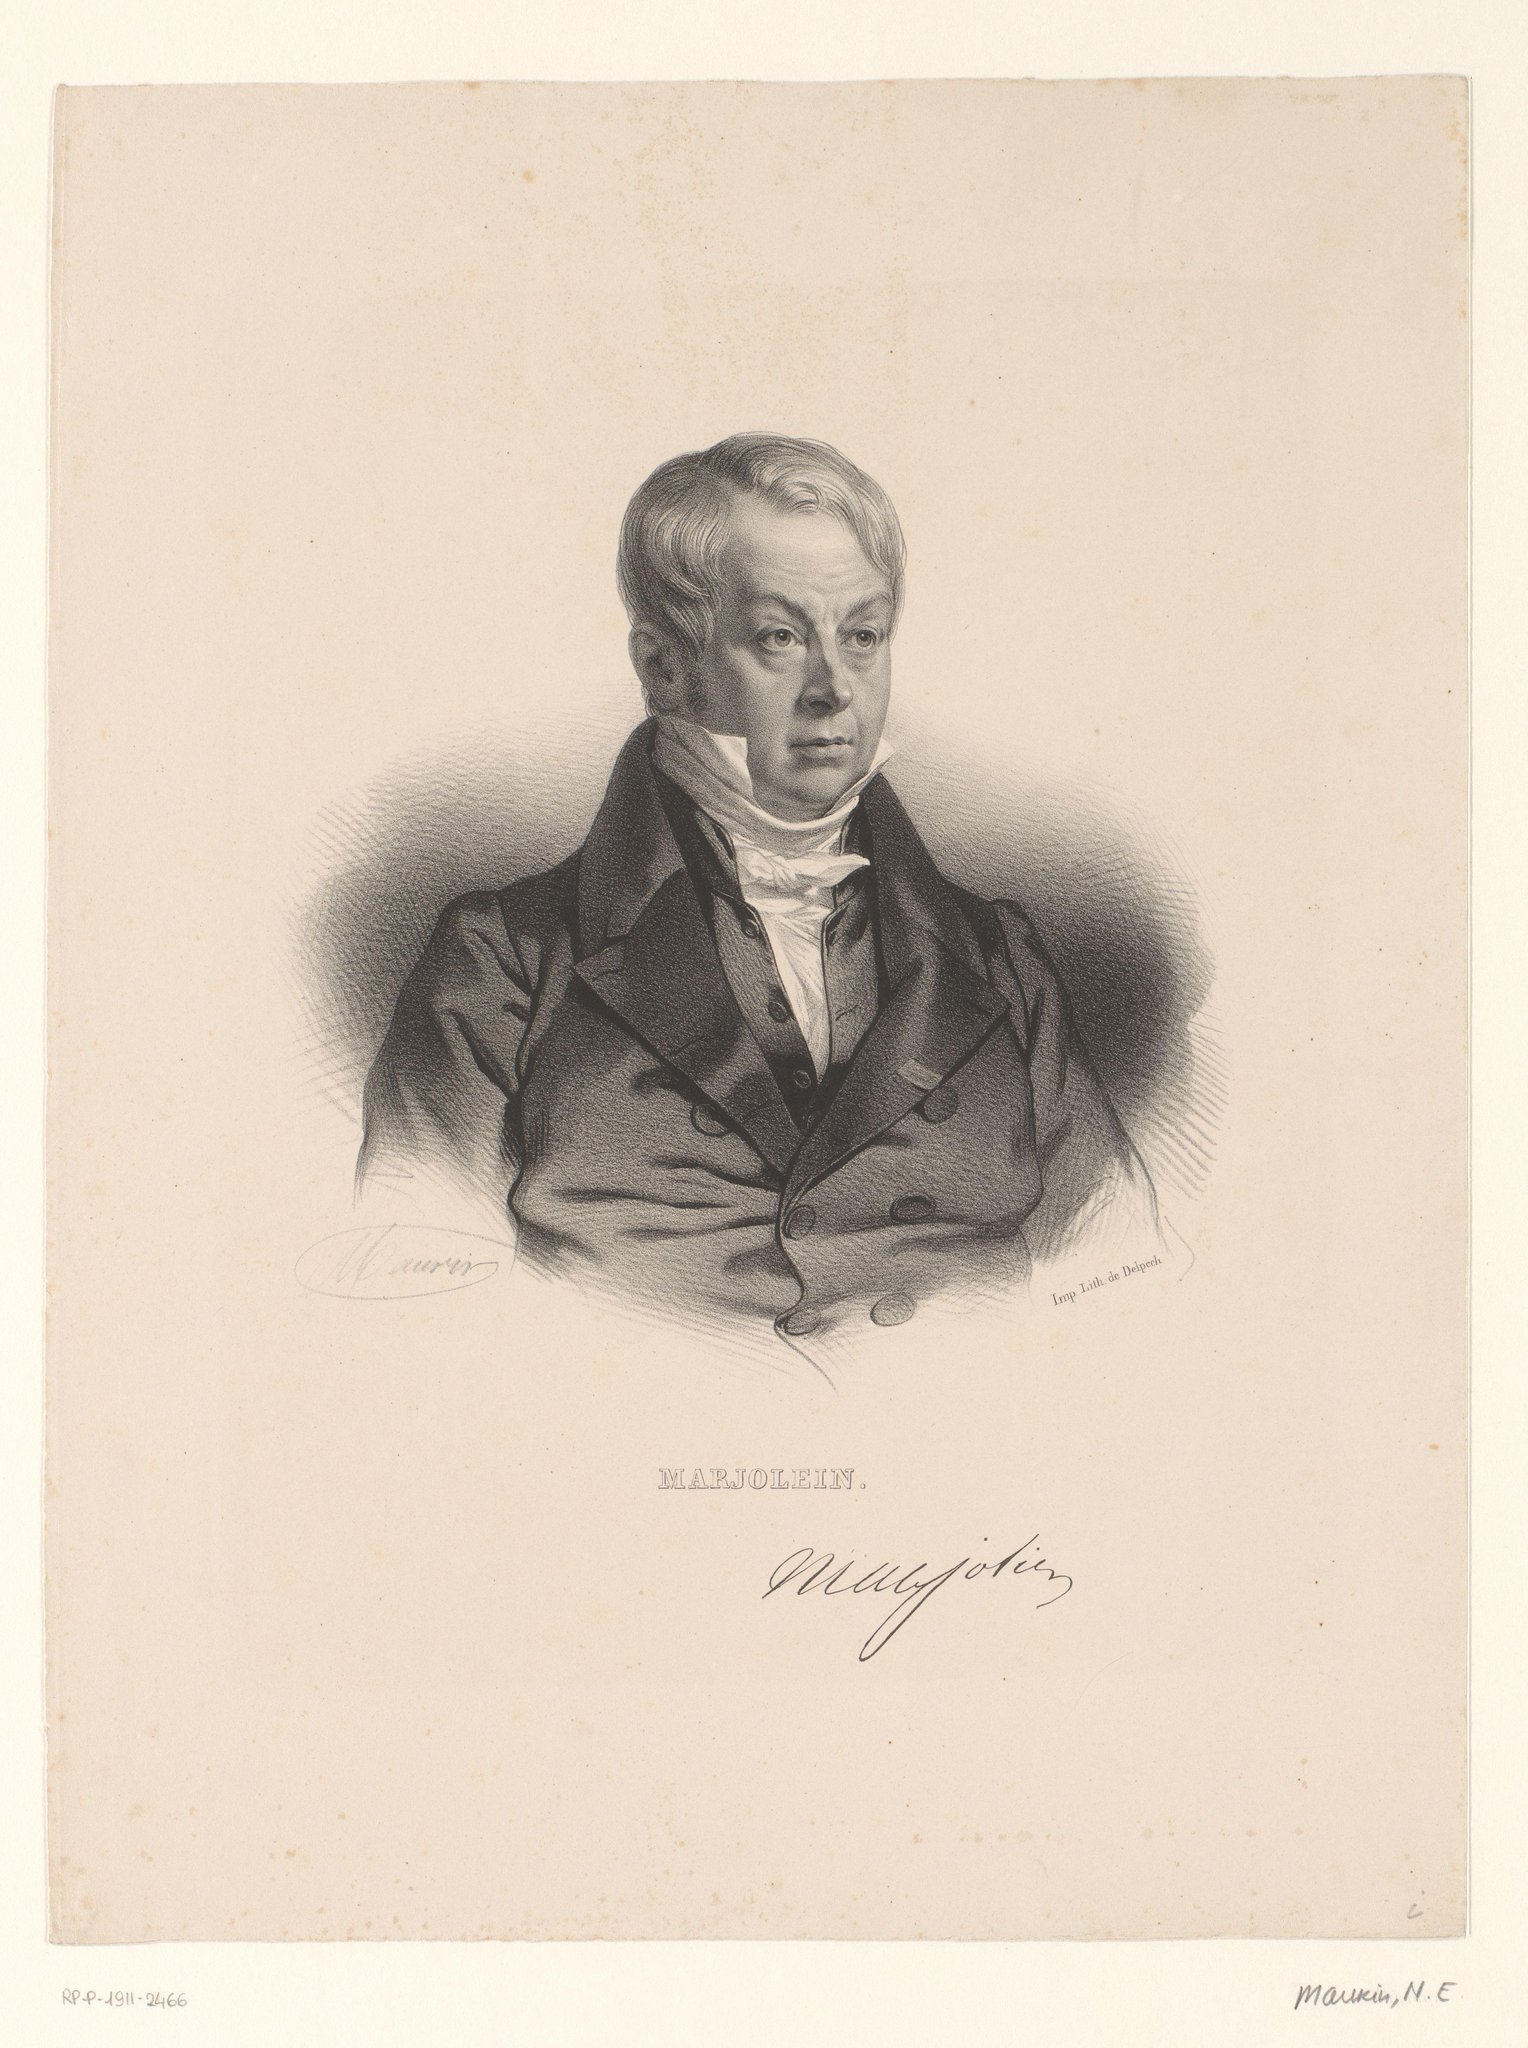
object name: print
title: Portret van Jean-Nicolas Marjolin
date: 1840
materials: paper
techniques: lithograph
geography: paris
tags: historical persons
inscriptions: collector's mark: Lugt 2228